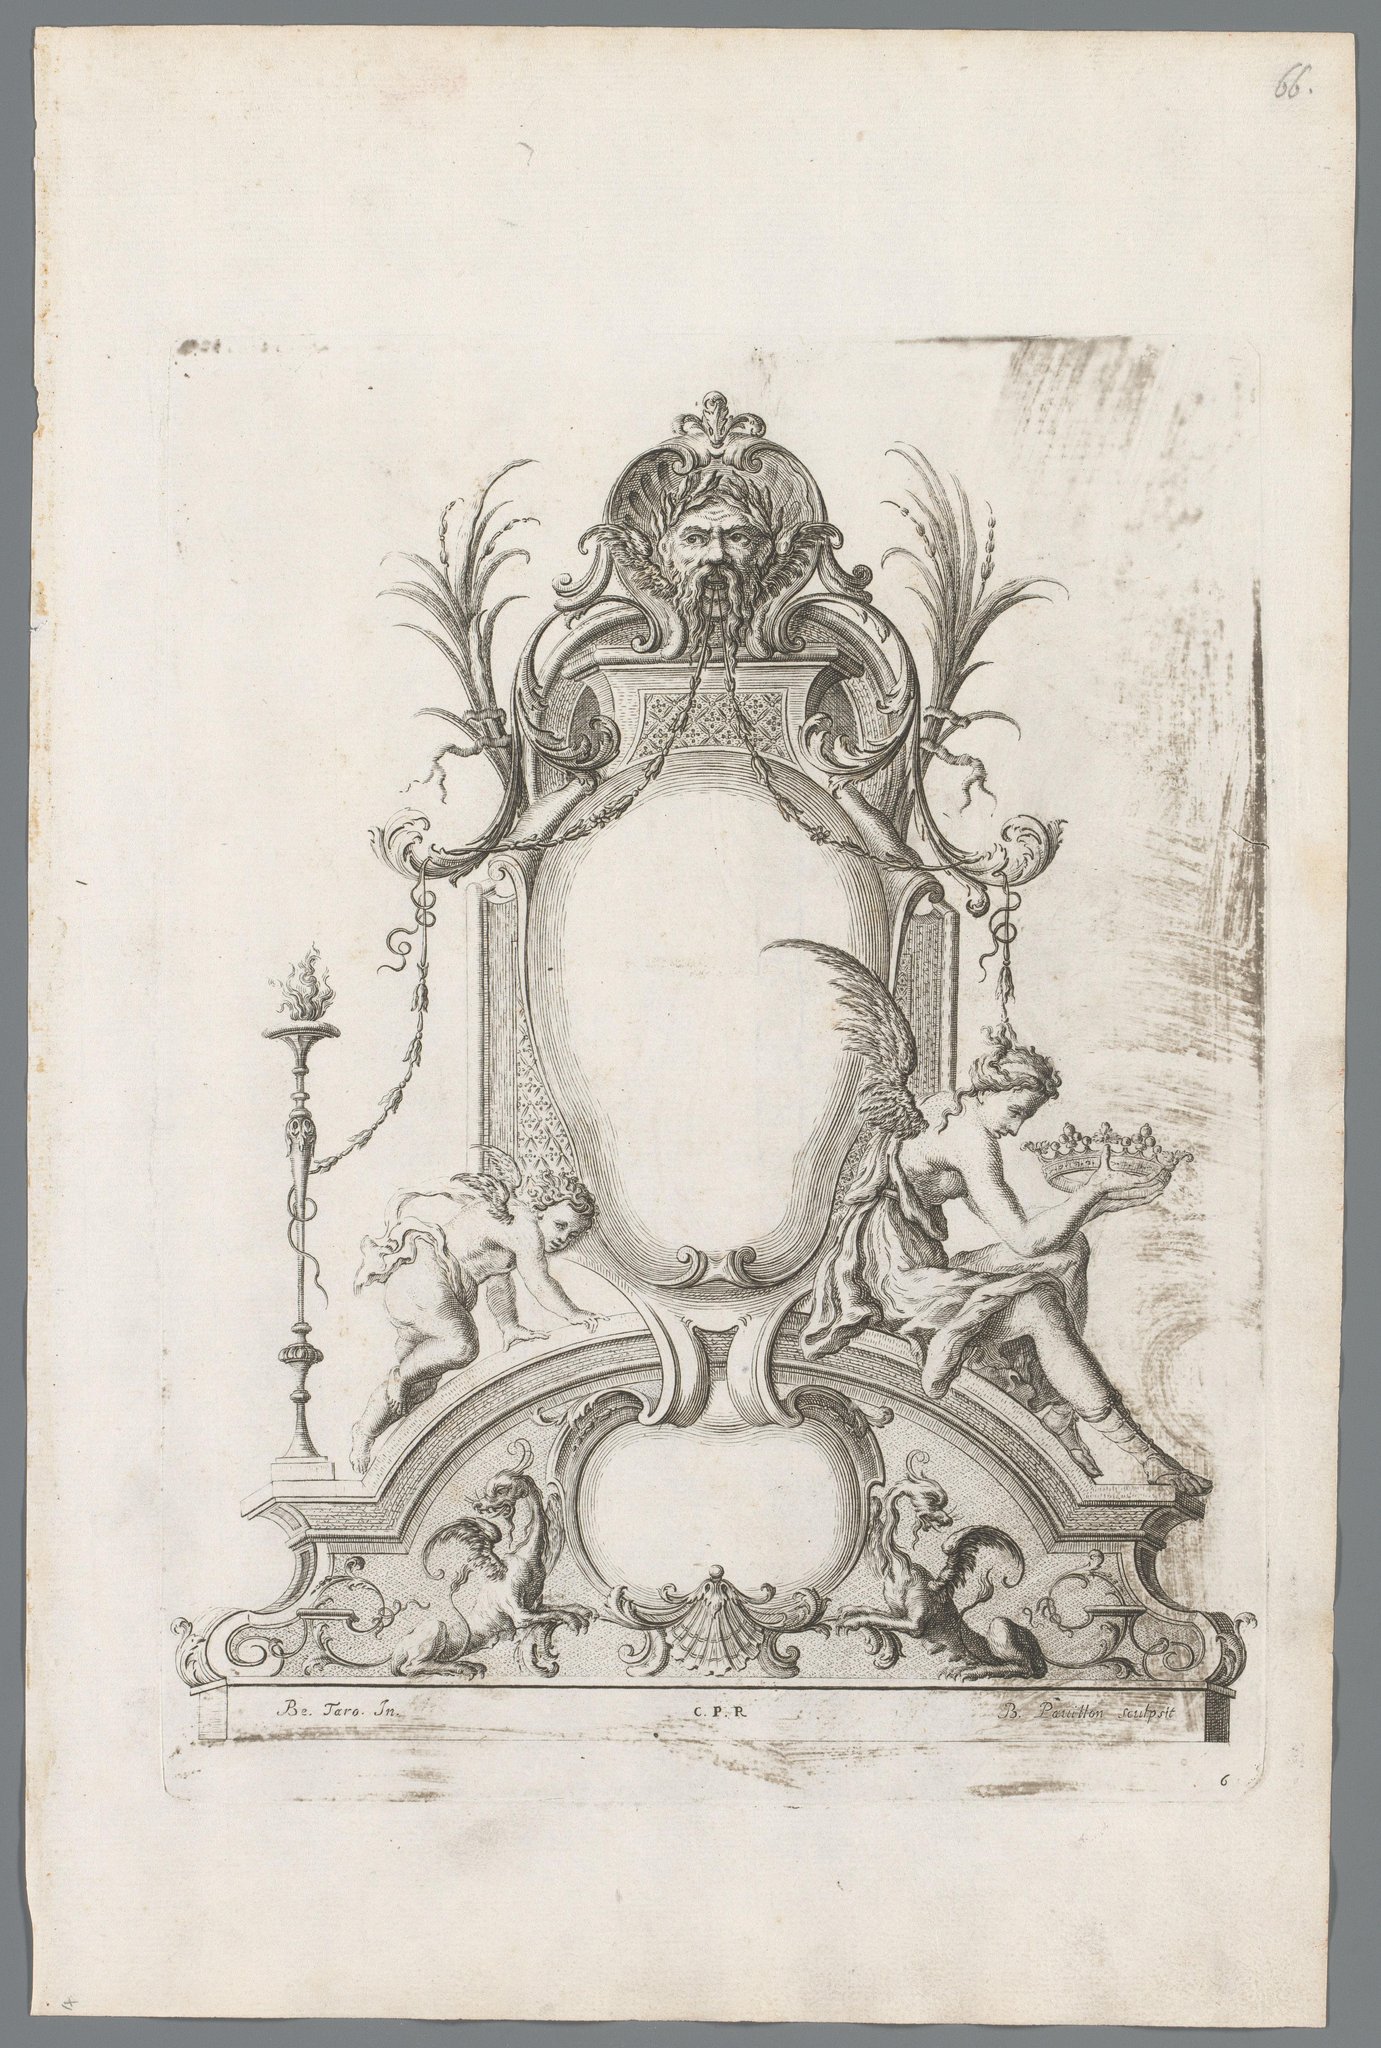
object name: print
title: Decoratief cartouche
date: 1682-1729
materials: paper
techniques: etching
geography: aix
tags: ornament ~ cartouche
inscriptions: collector's mark: Lugt 2760, collector's mark: Lugt 2228